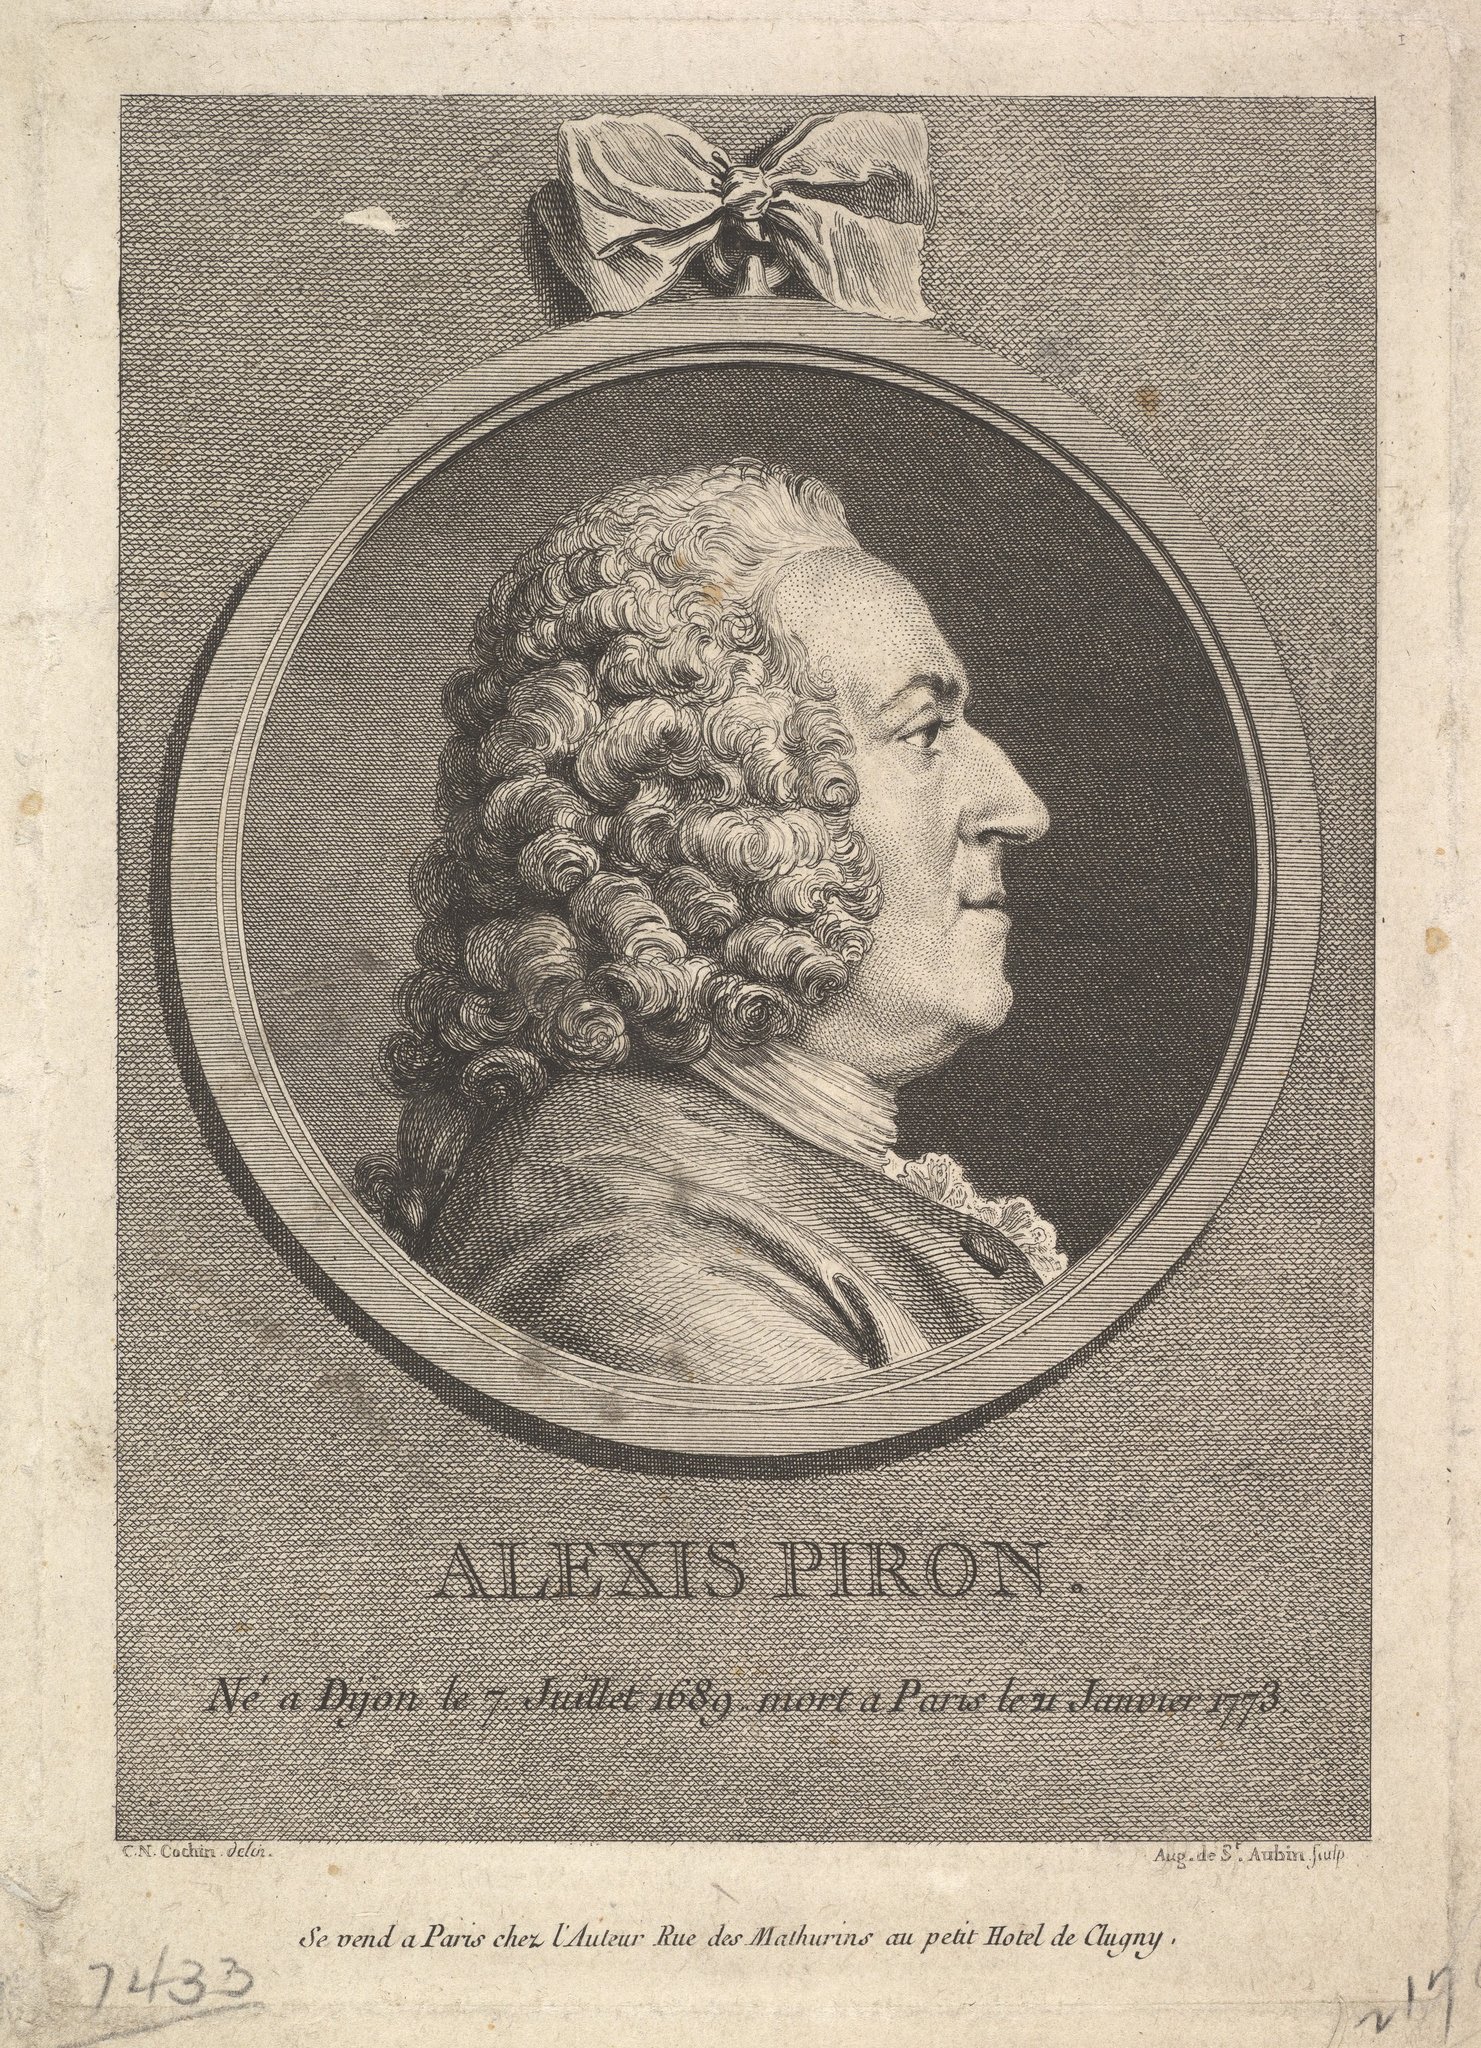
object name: print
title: Portrait of Alexis Piron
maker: augustin de saint-aubin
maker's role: artist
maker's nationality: french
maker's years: 1736-1807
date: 1776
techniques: engraving, etching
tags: men,portraits